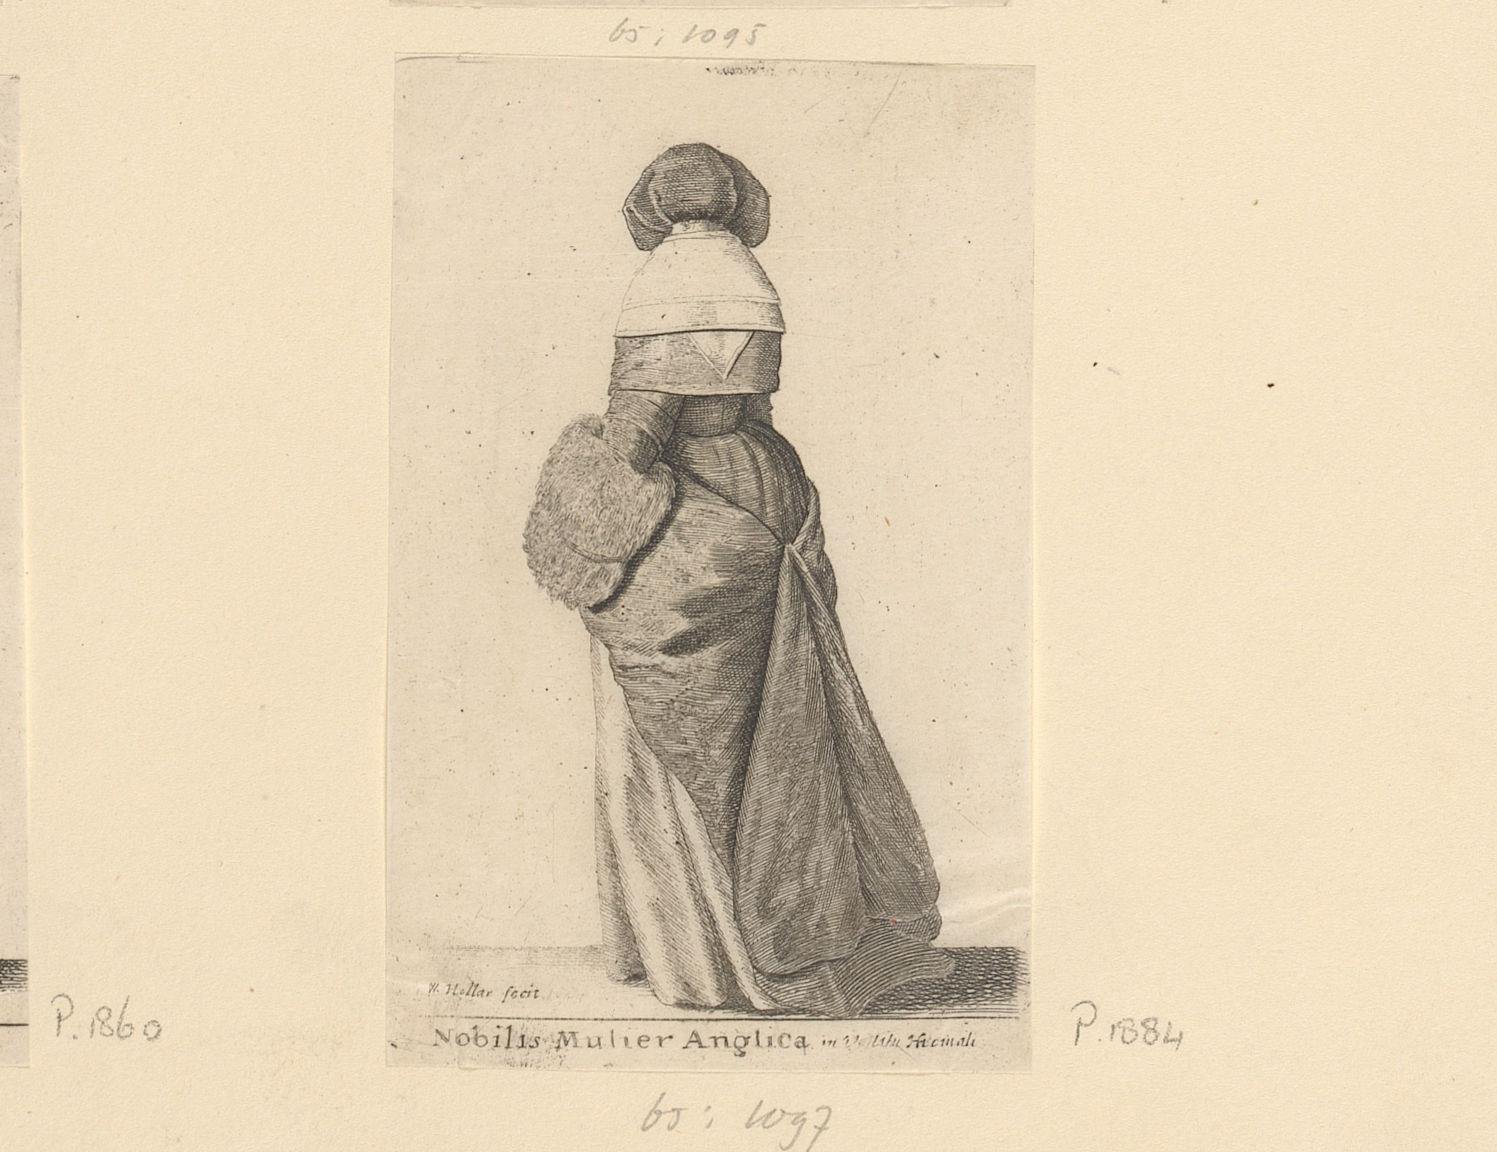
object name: album leaf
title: Nobilis Mulier Anglica, in Vestitu Hiemali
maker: wenceslaus hollar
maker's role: draughtsman, print maker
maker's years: 1607-1677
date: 1643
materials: paper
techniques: etching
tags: adult woman, folk costume, regional costume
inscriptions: date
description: Prent maakt mogelijk deel uit van een serie van 200 prenten. Deze serie is onder de titel 'A Collection of two hundred original etchings' voor het eerst uitgegeven door J.M. Greery in 1816.